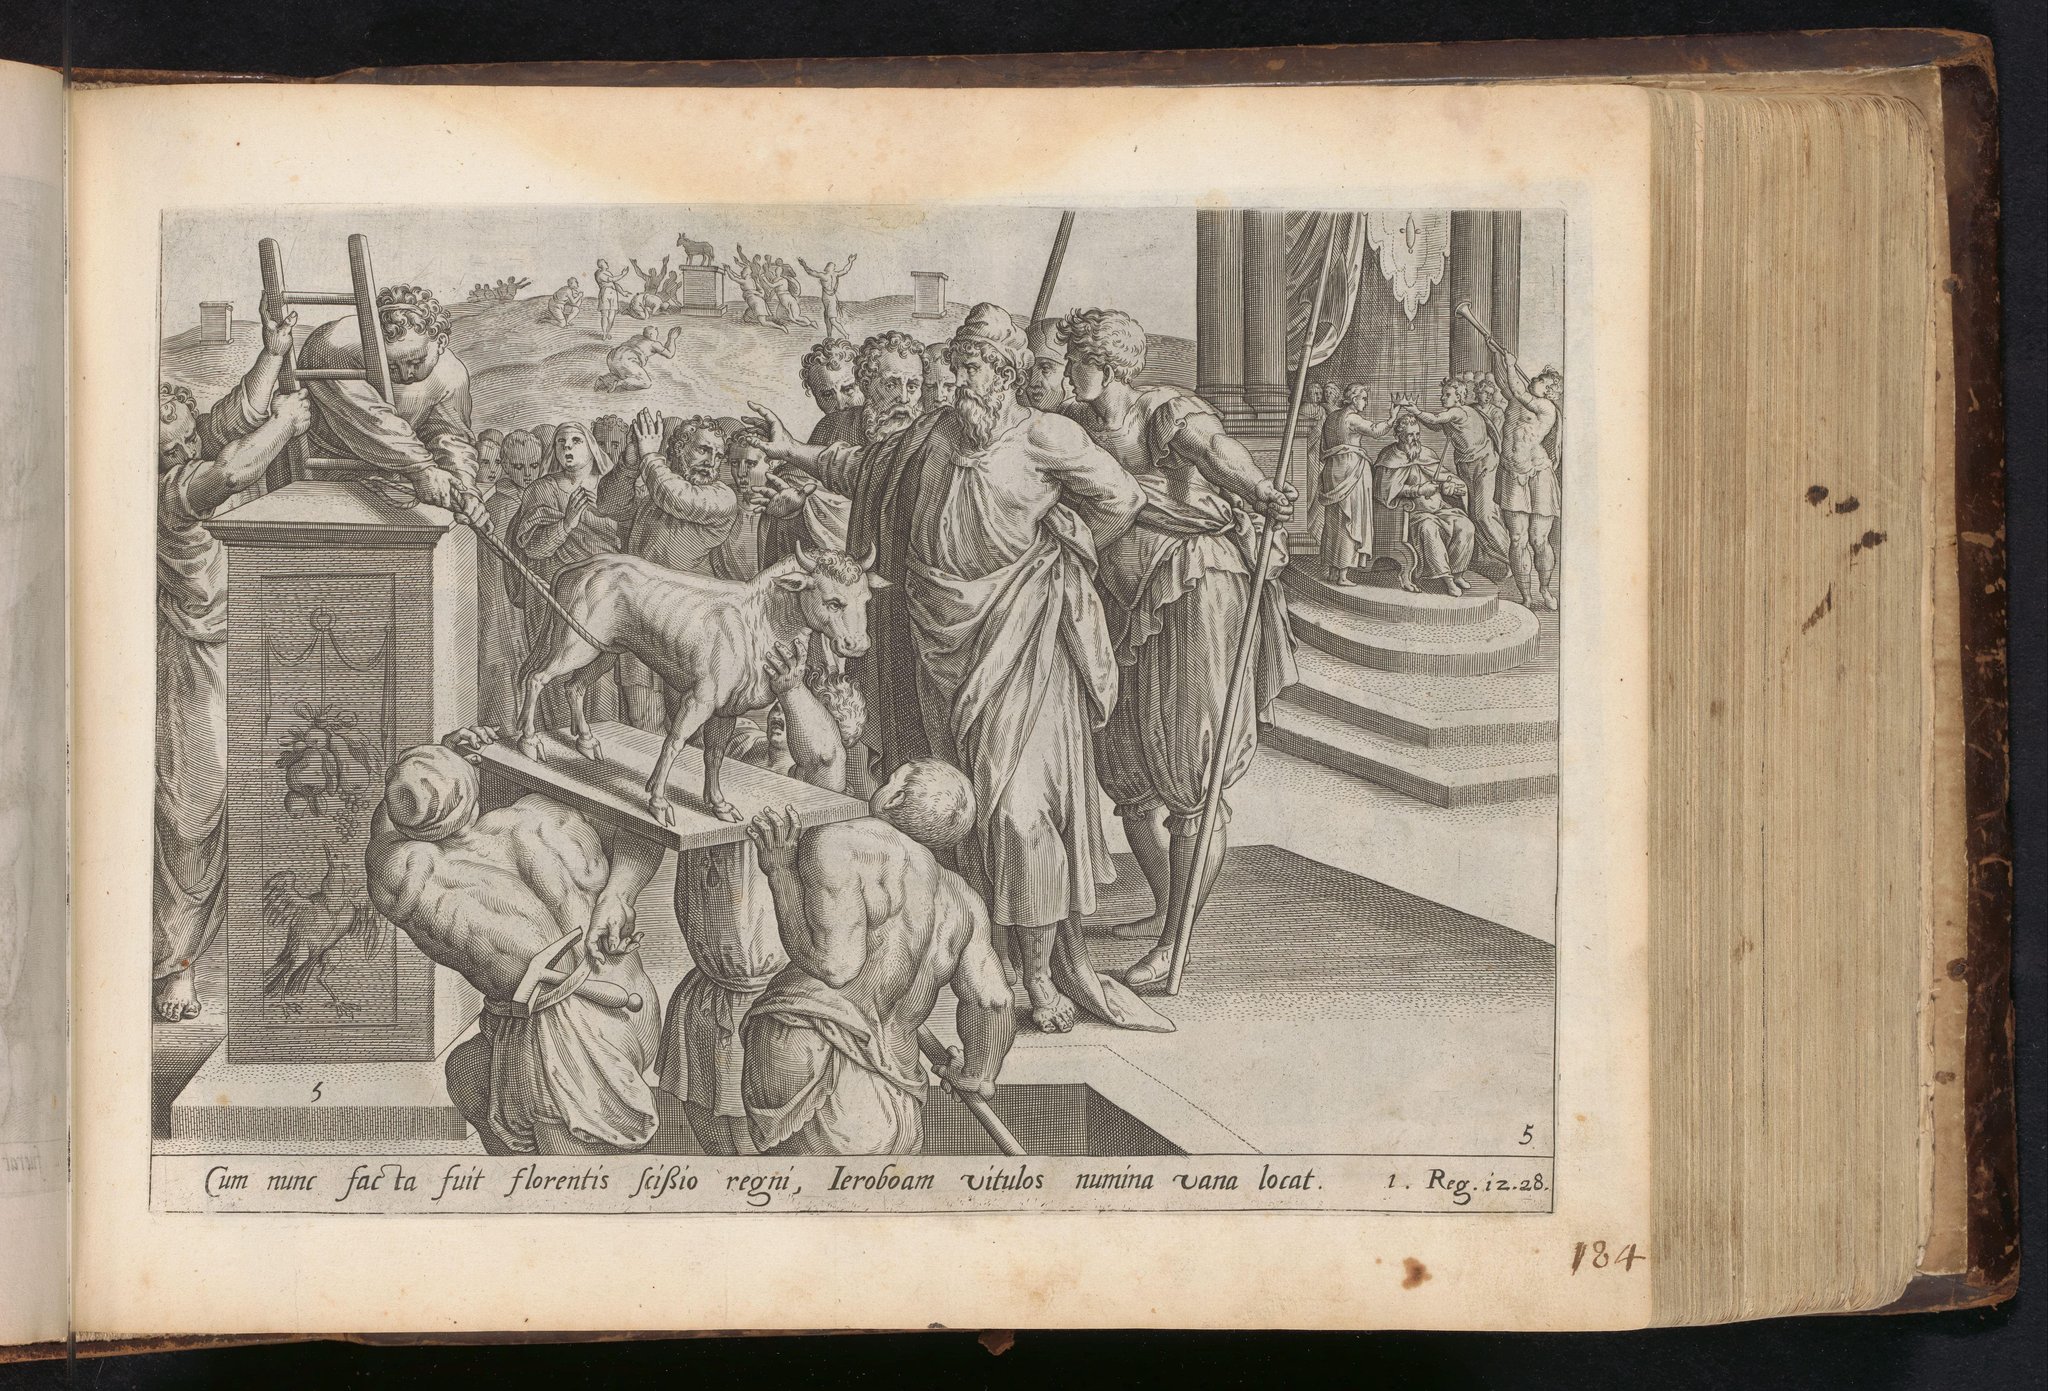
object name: print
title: Geschiedenis van Jerobeam en Rechabeam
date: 1579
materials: paper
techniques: engraving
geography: amsterdam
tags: jeroboam sets up two golden calves, one in bethel and one in dan, the ten northern tribes make jeroboam king of israel and set up the capital of shechem (later exchanged for tirzah)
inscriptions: number: ‘184’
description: Onder leiding van Jerobeam wordt een gouden beeld van stierkalf op een sokkel gehesen. Op de achtergrond aanbidden de Israëlieten het andere stierkalf. Rechts op de achtergrond de kroning van Jerobeam. Onder de voorstelling een verwijzing in het Latijn naar de Bijbeltekst in 1 Kon. 12:28. Deze prent maakt deel uit van een album.